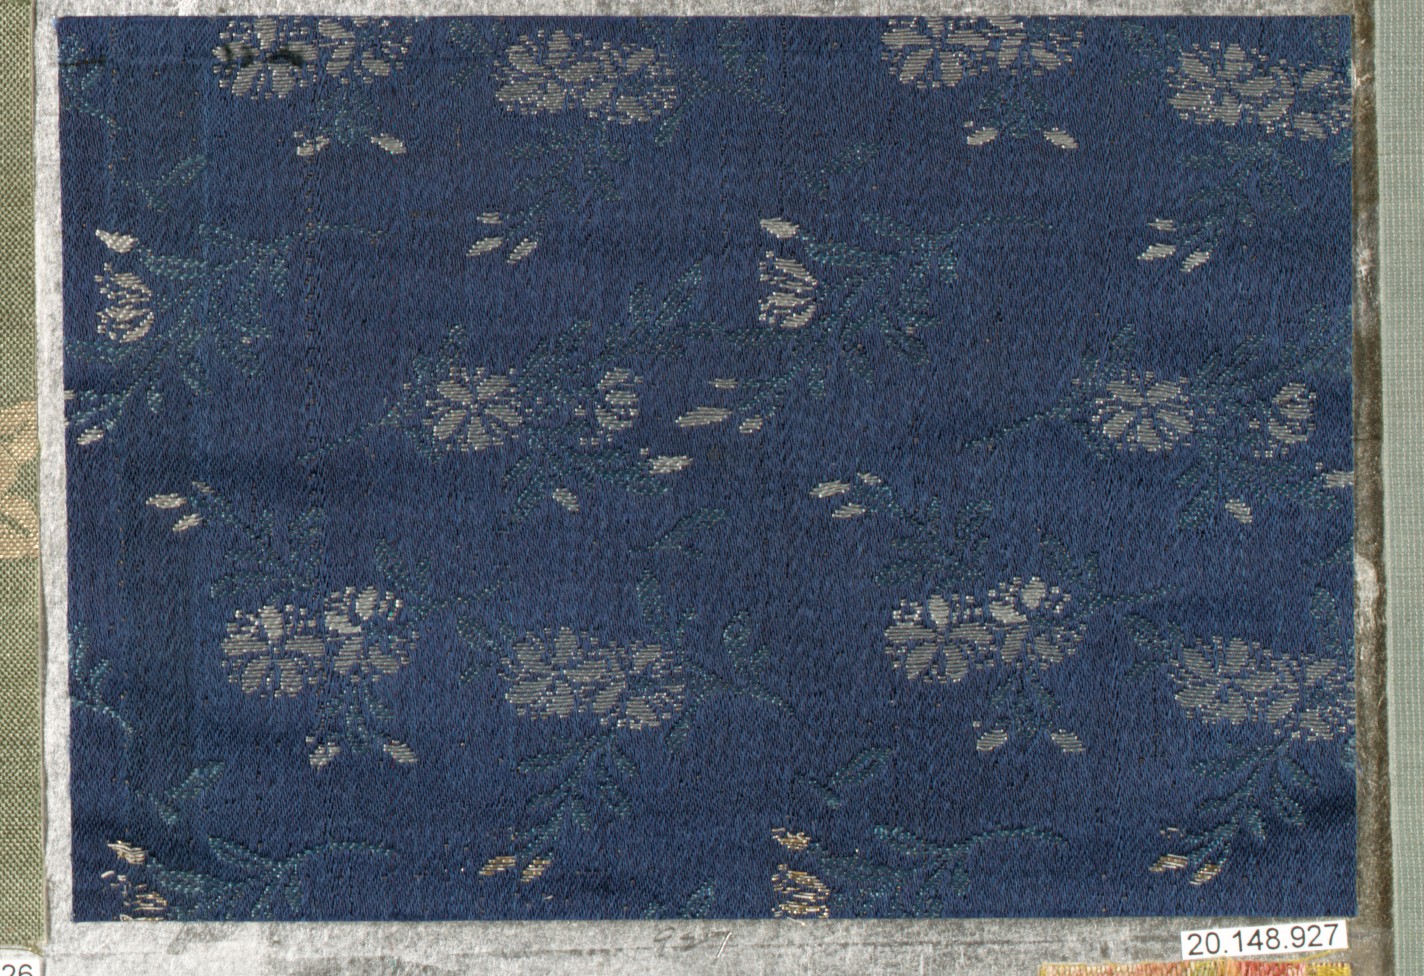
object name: piece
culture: japanese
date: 1701-1800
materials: silk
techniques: compound weave